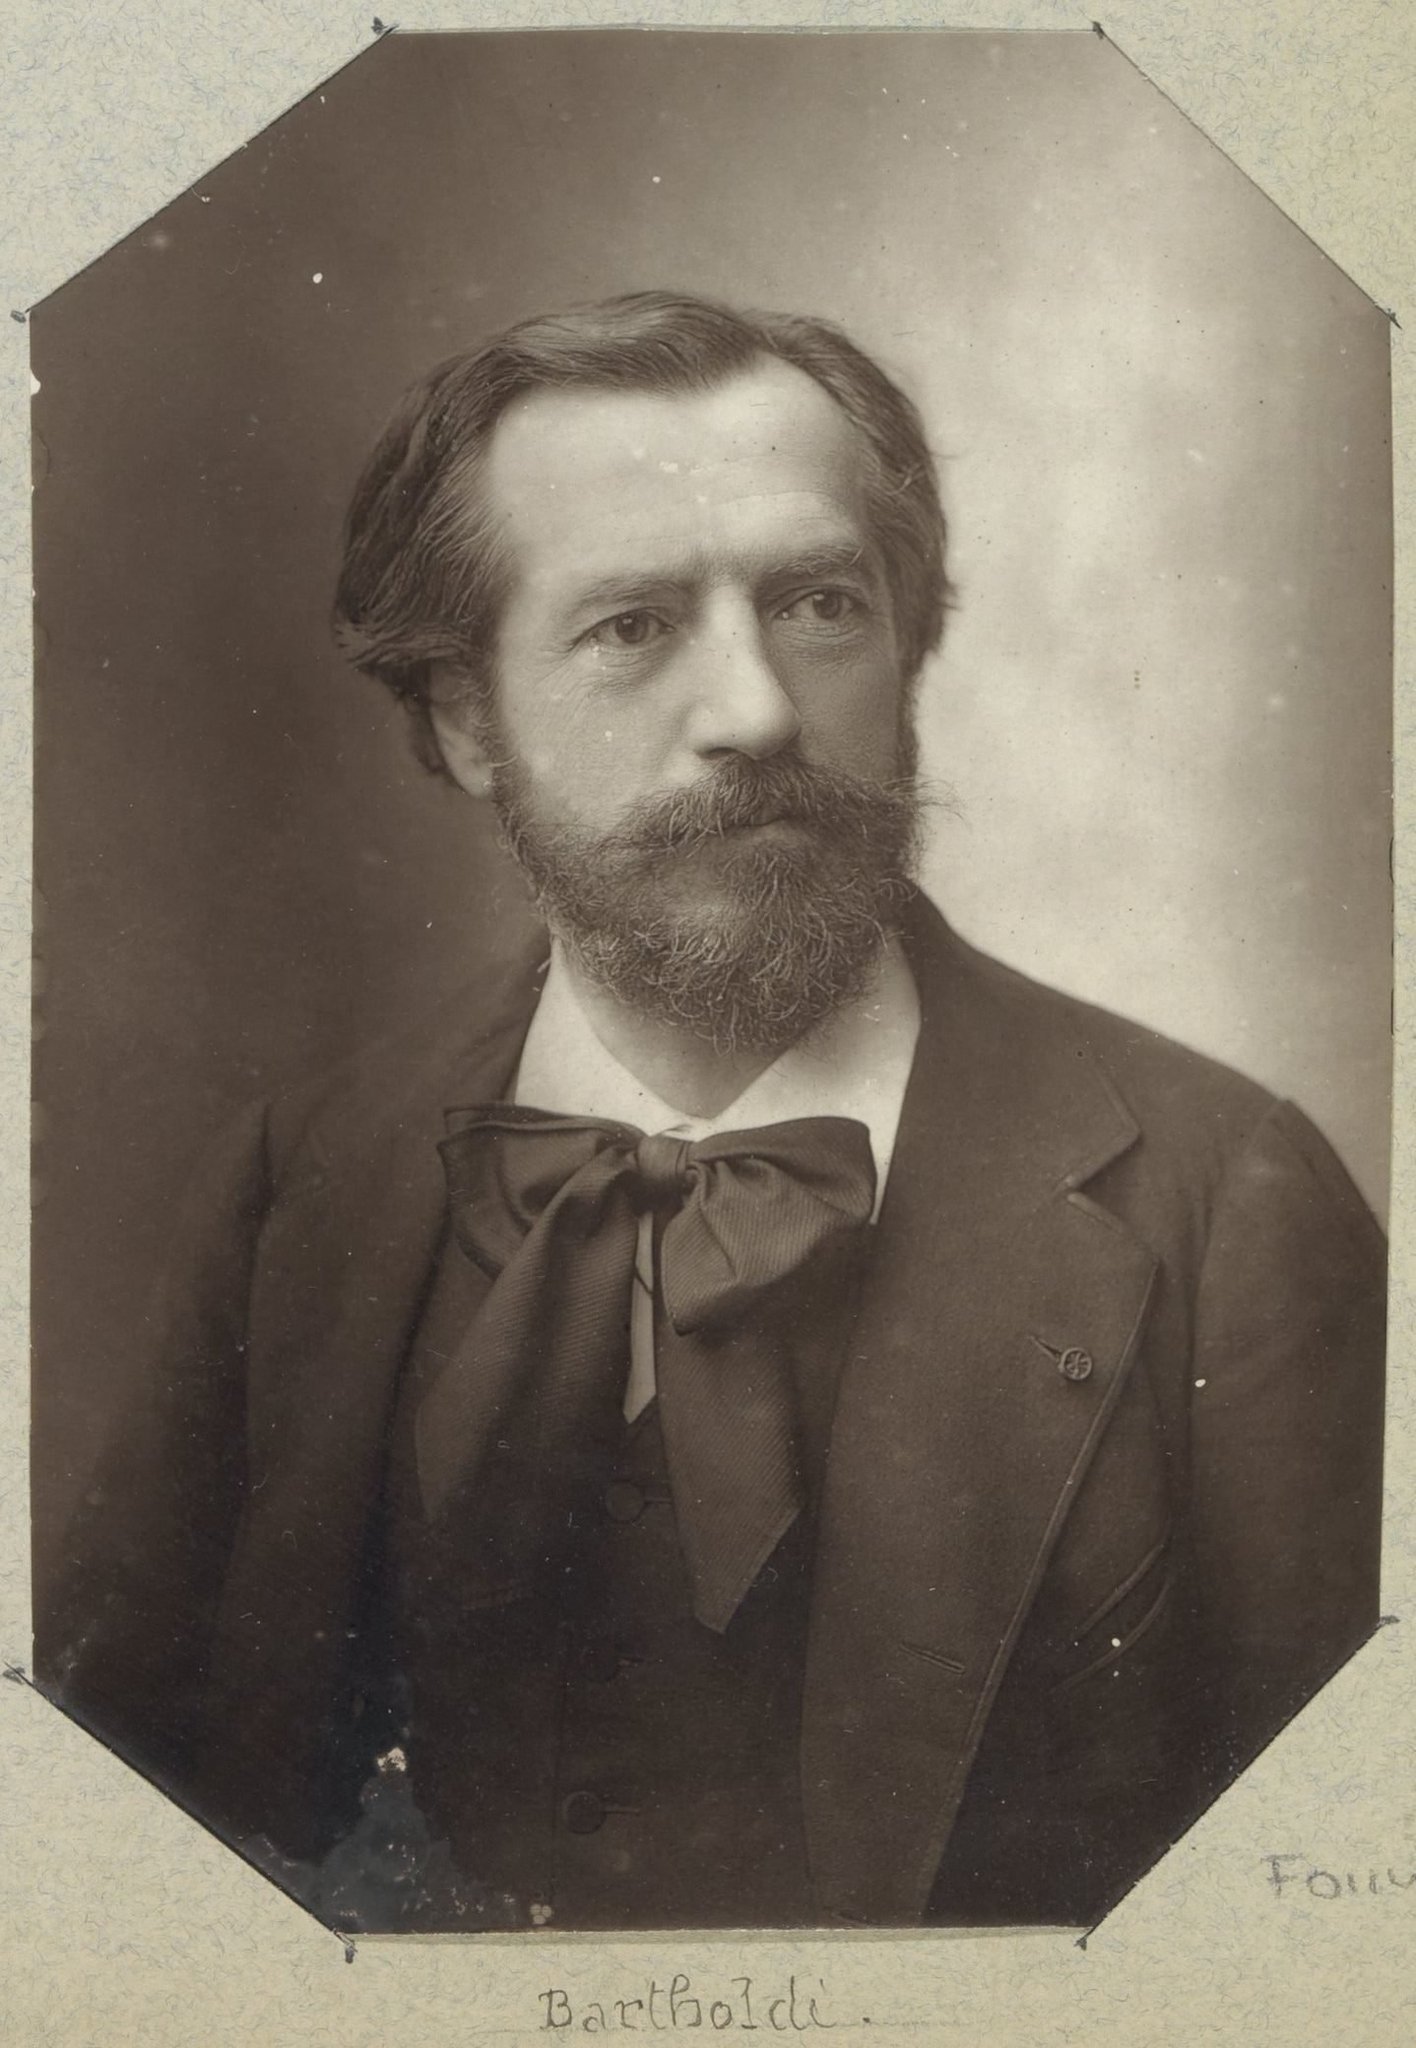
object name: photograph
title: Portret van Frédéric Auguste Bartholdi, beeldhouwer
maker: Anonymous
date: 1880-1900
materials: paper, photographic support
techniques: carbon print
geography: france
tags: paris, sculptor, frédéric auguste bartholdi, portrait, self-portrait of sculptor, france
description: Onderdeel van Album van een Franse amateur met foto's van Frankrijk, Algerije, Palmyra, de Wereldtentoonstelling van 1900 en van bekende Fransen.